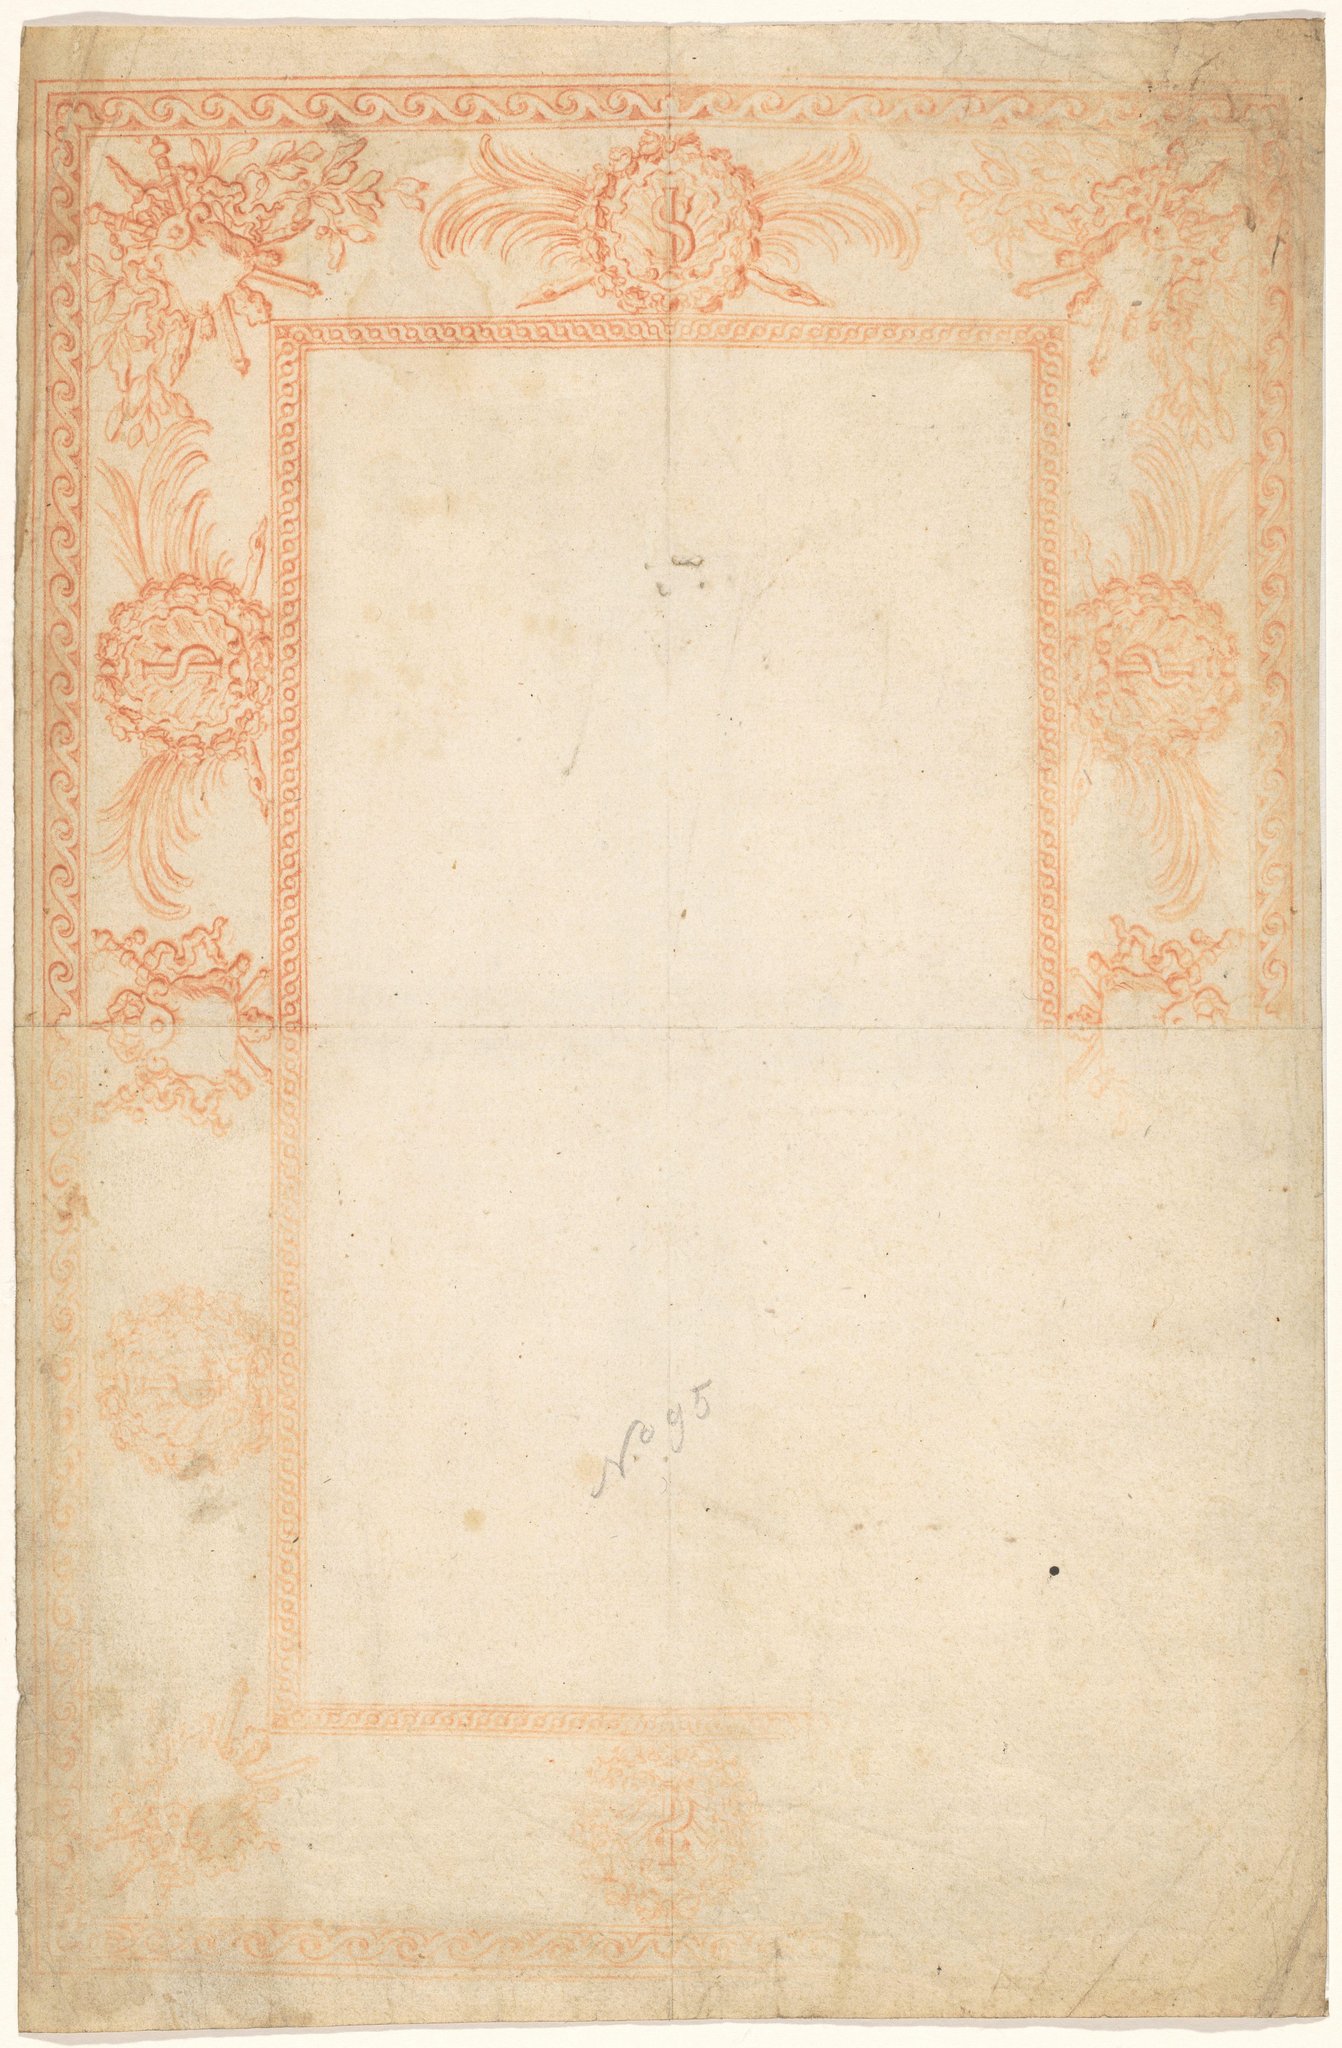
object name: design drawing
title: Ontwerp voor het beslag van een boekband, met het monogram IS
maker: Anonymous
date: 1700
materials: chalk, paper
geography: paris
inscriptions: watermark, number: ‘No. 95’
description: Het linker bovenste kwart van de band is in rood krijt getekend, het rechter kwart is verkregen door daar een contre-épreuve van te nemen, en de onderste helft is vervolgens verkregen als contre-épreuve van de bovenste.